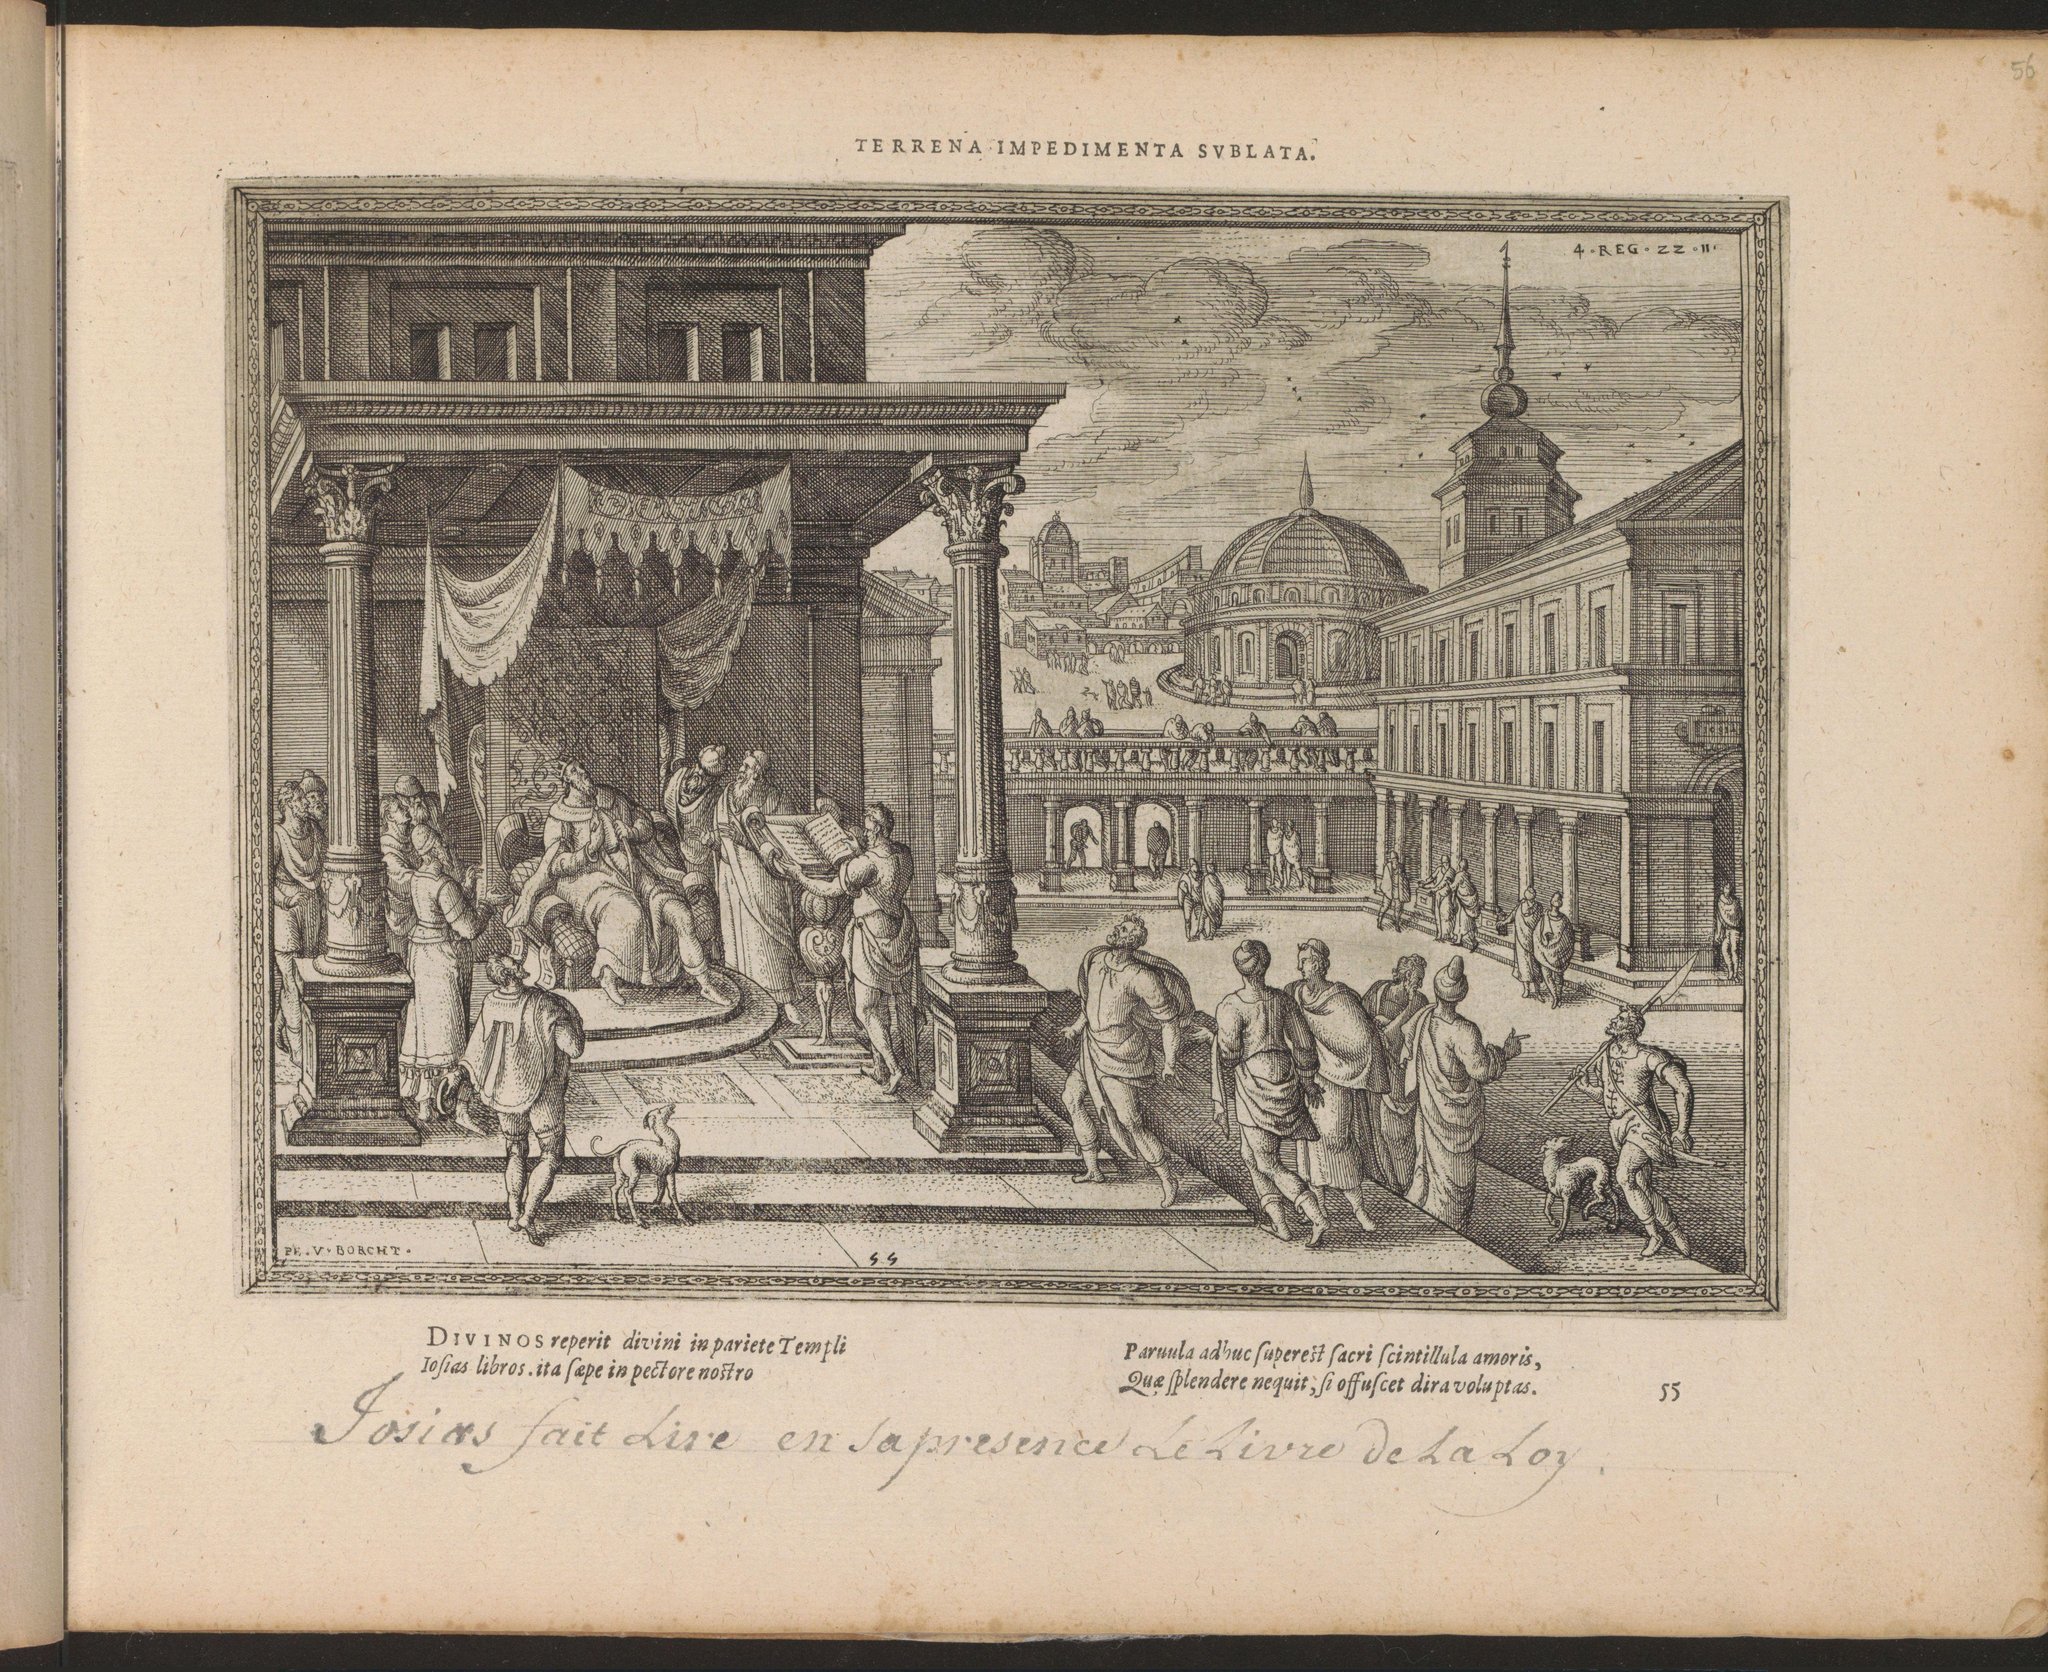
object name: album leaf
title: Koning Josia scheurt zijn kleren bij het horen van de woorden uit het wetboek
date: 1582-1593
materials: paper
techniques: etching, letterpress printing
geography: amsterdam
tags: saphan reads the book of law aloud to the king who tears his clothes in dismay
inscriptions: inscription: ‘Josias fait lire en sa presence le livre de la loy’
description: Koning Josia zit op zijn troon onder een baldakijn en omgeven door leden van zijn hof. Naast hem leest zijn hofschrijver Safia voor uit het wetboek op de lezenaar. Bij het horen van de woorden van Safia scheurt de koning zijn mantel (2. Kon. 22:11). Rechts een ander deel van het paleis en een muur met twee poorten. In de verte een koepel. Met een motto in het Latijn boven de voorstelling en een vierregelig onderschrift in het Latijn onder de prent. De prent maakt deel uit van een album.